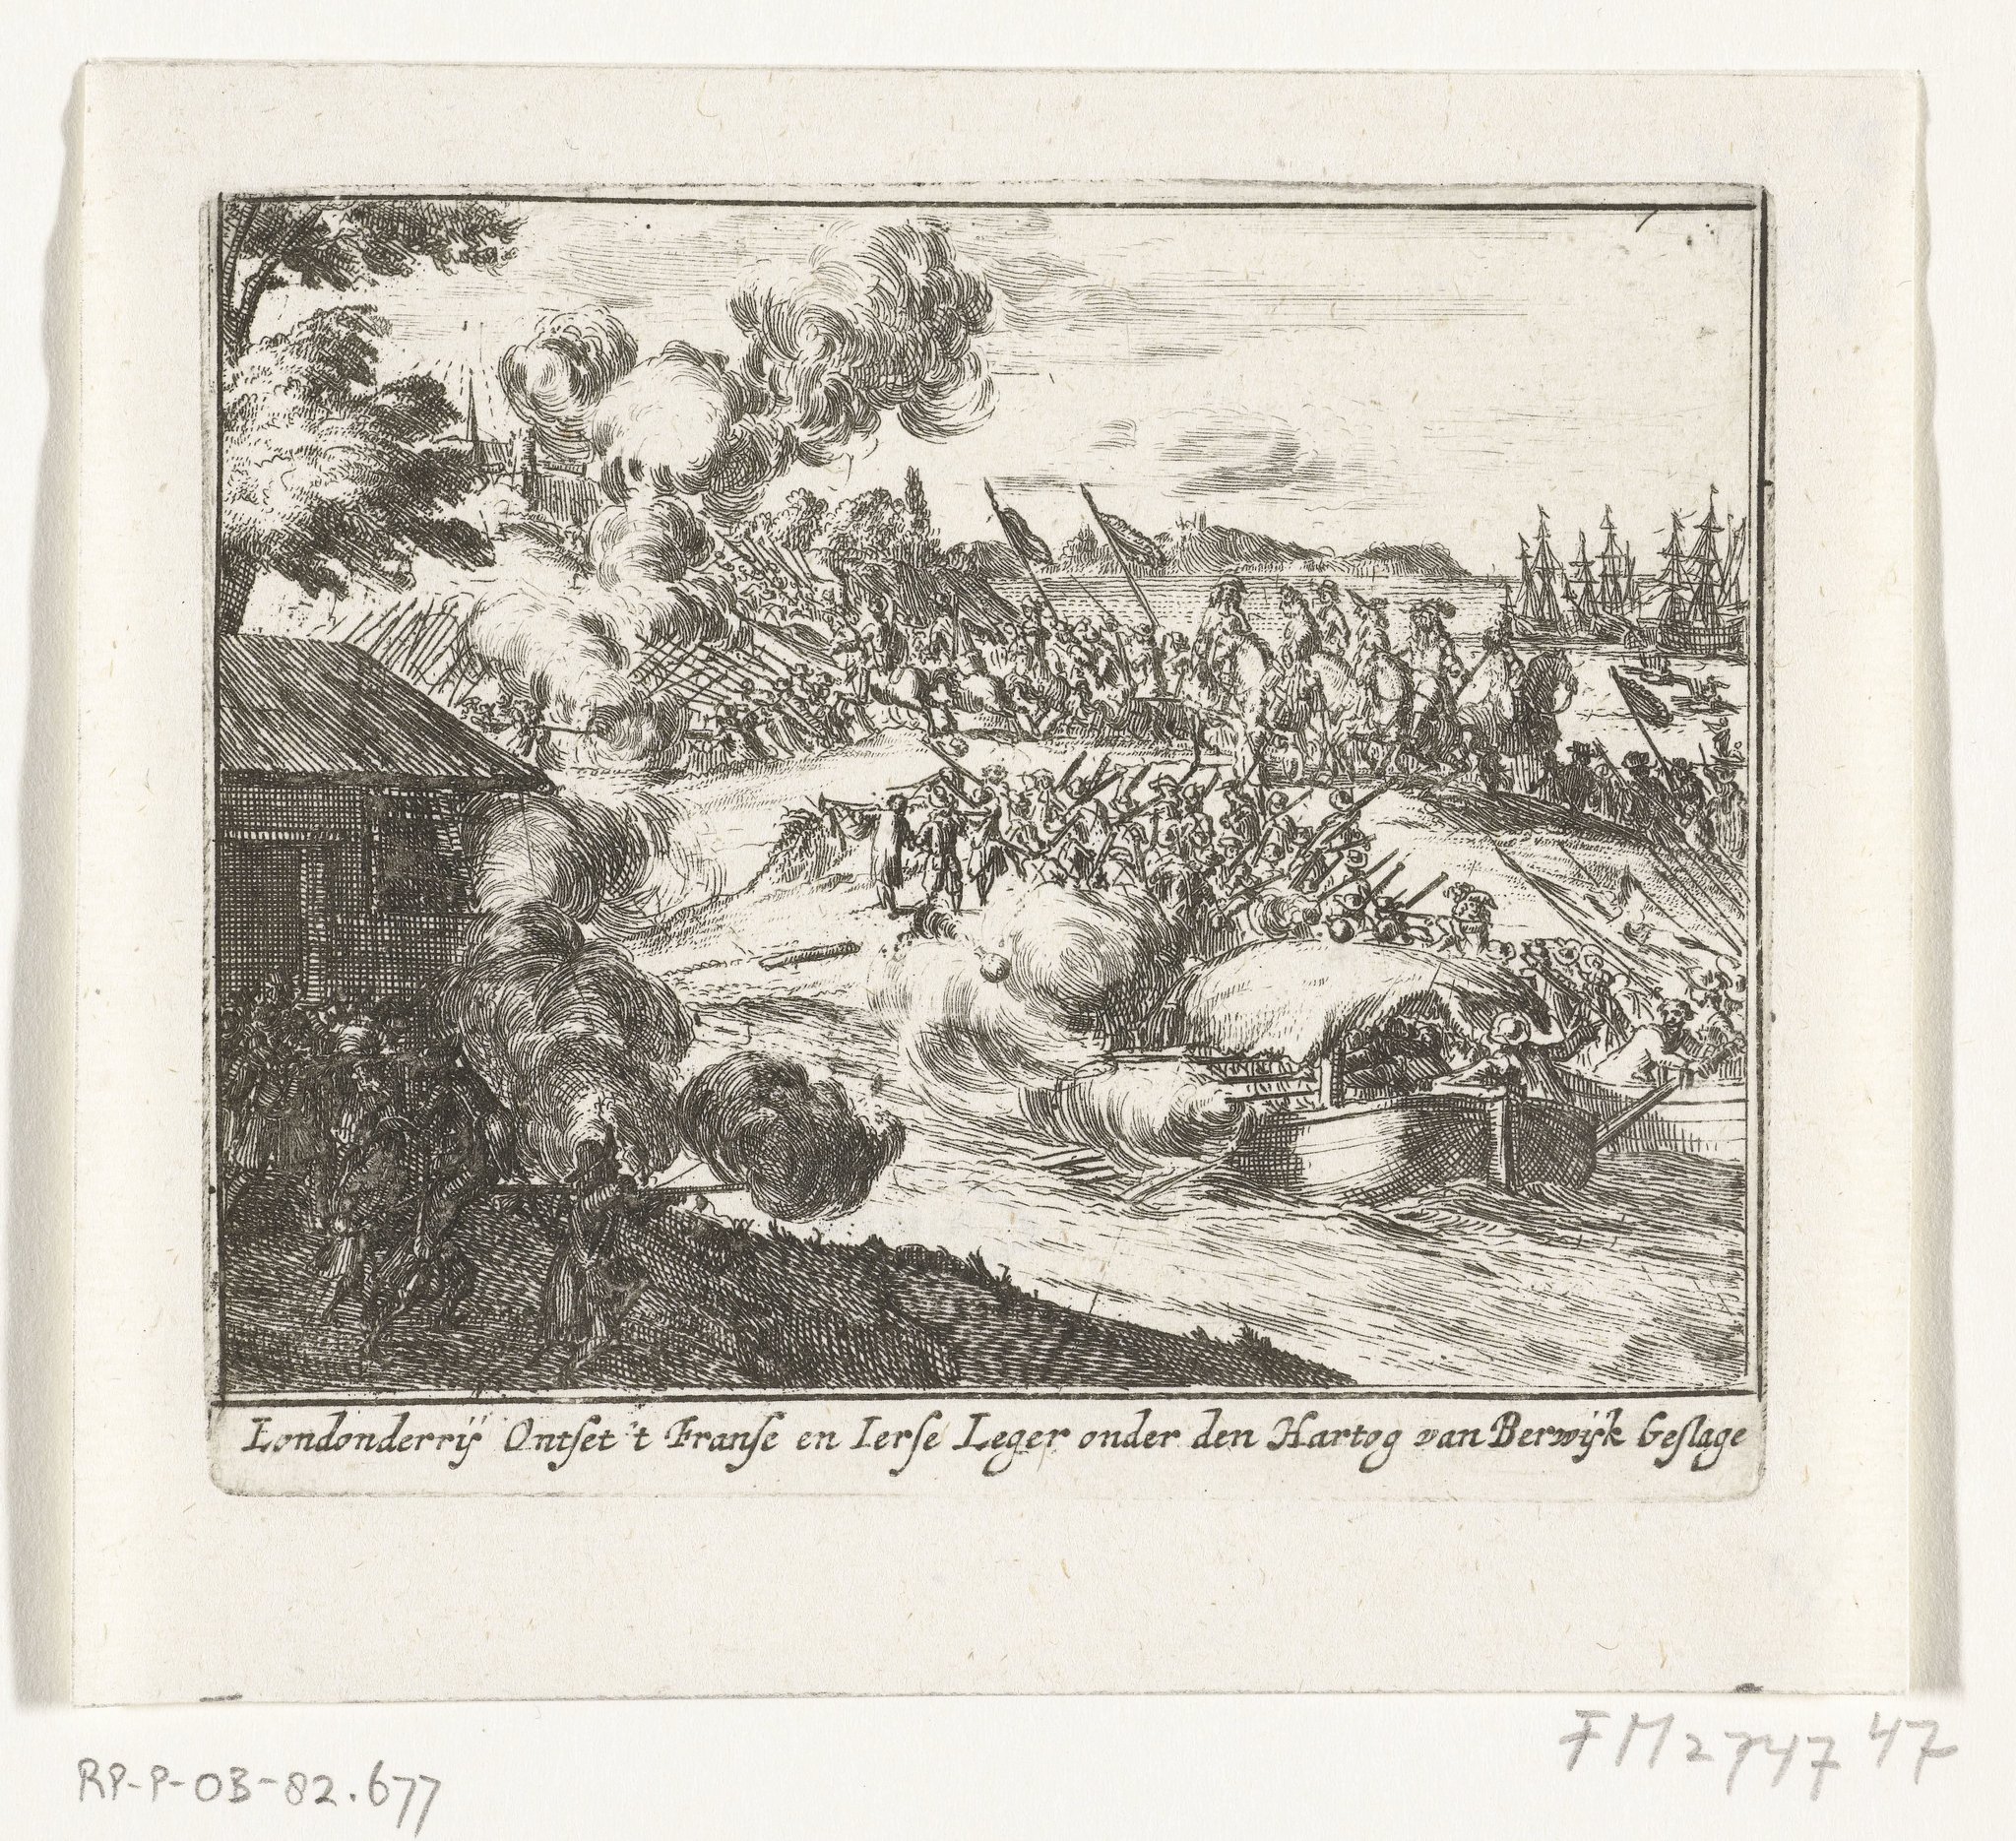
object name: print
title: Ontzet van Londonderry, 1689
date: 1711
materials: paper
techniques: etching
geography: northern netherlands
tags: jacobus ii (koning van engeland en schotland), raising the siege with outside assistance, relief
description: Ontzet van Londonderry op 28 juli 1689 na tevergeefs vanaf 18 april door het leger van koning Jacobus II belegerd te zijn geweest. Onderdeel van een serie over de lotgevallen van het Engelse koningshuis van Stuart van 1558-1711, waarvan hier zijn opgenomen zestien prenten over de strijd tussen Jacobus II en Willem III in de jaren 1688-1689.